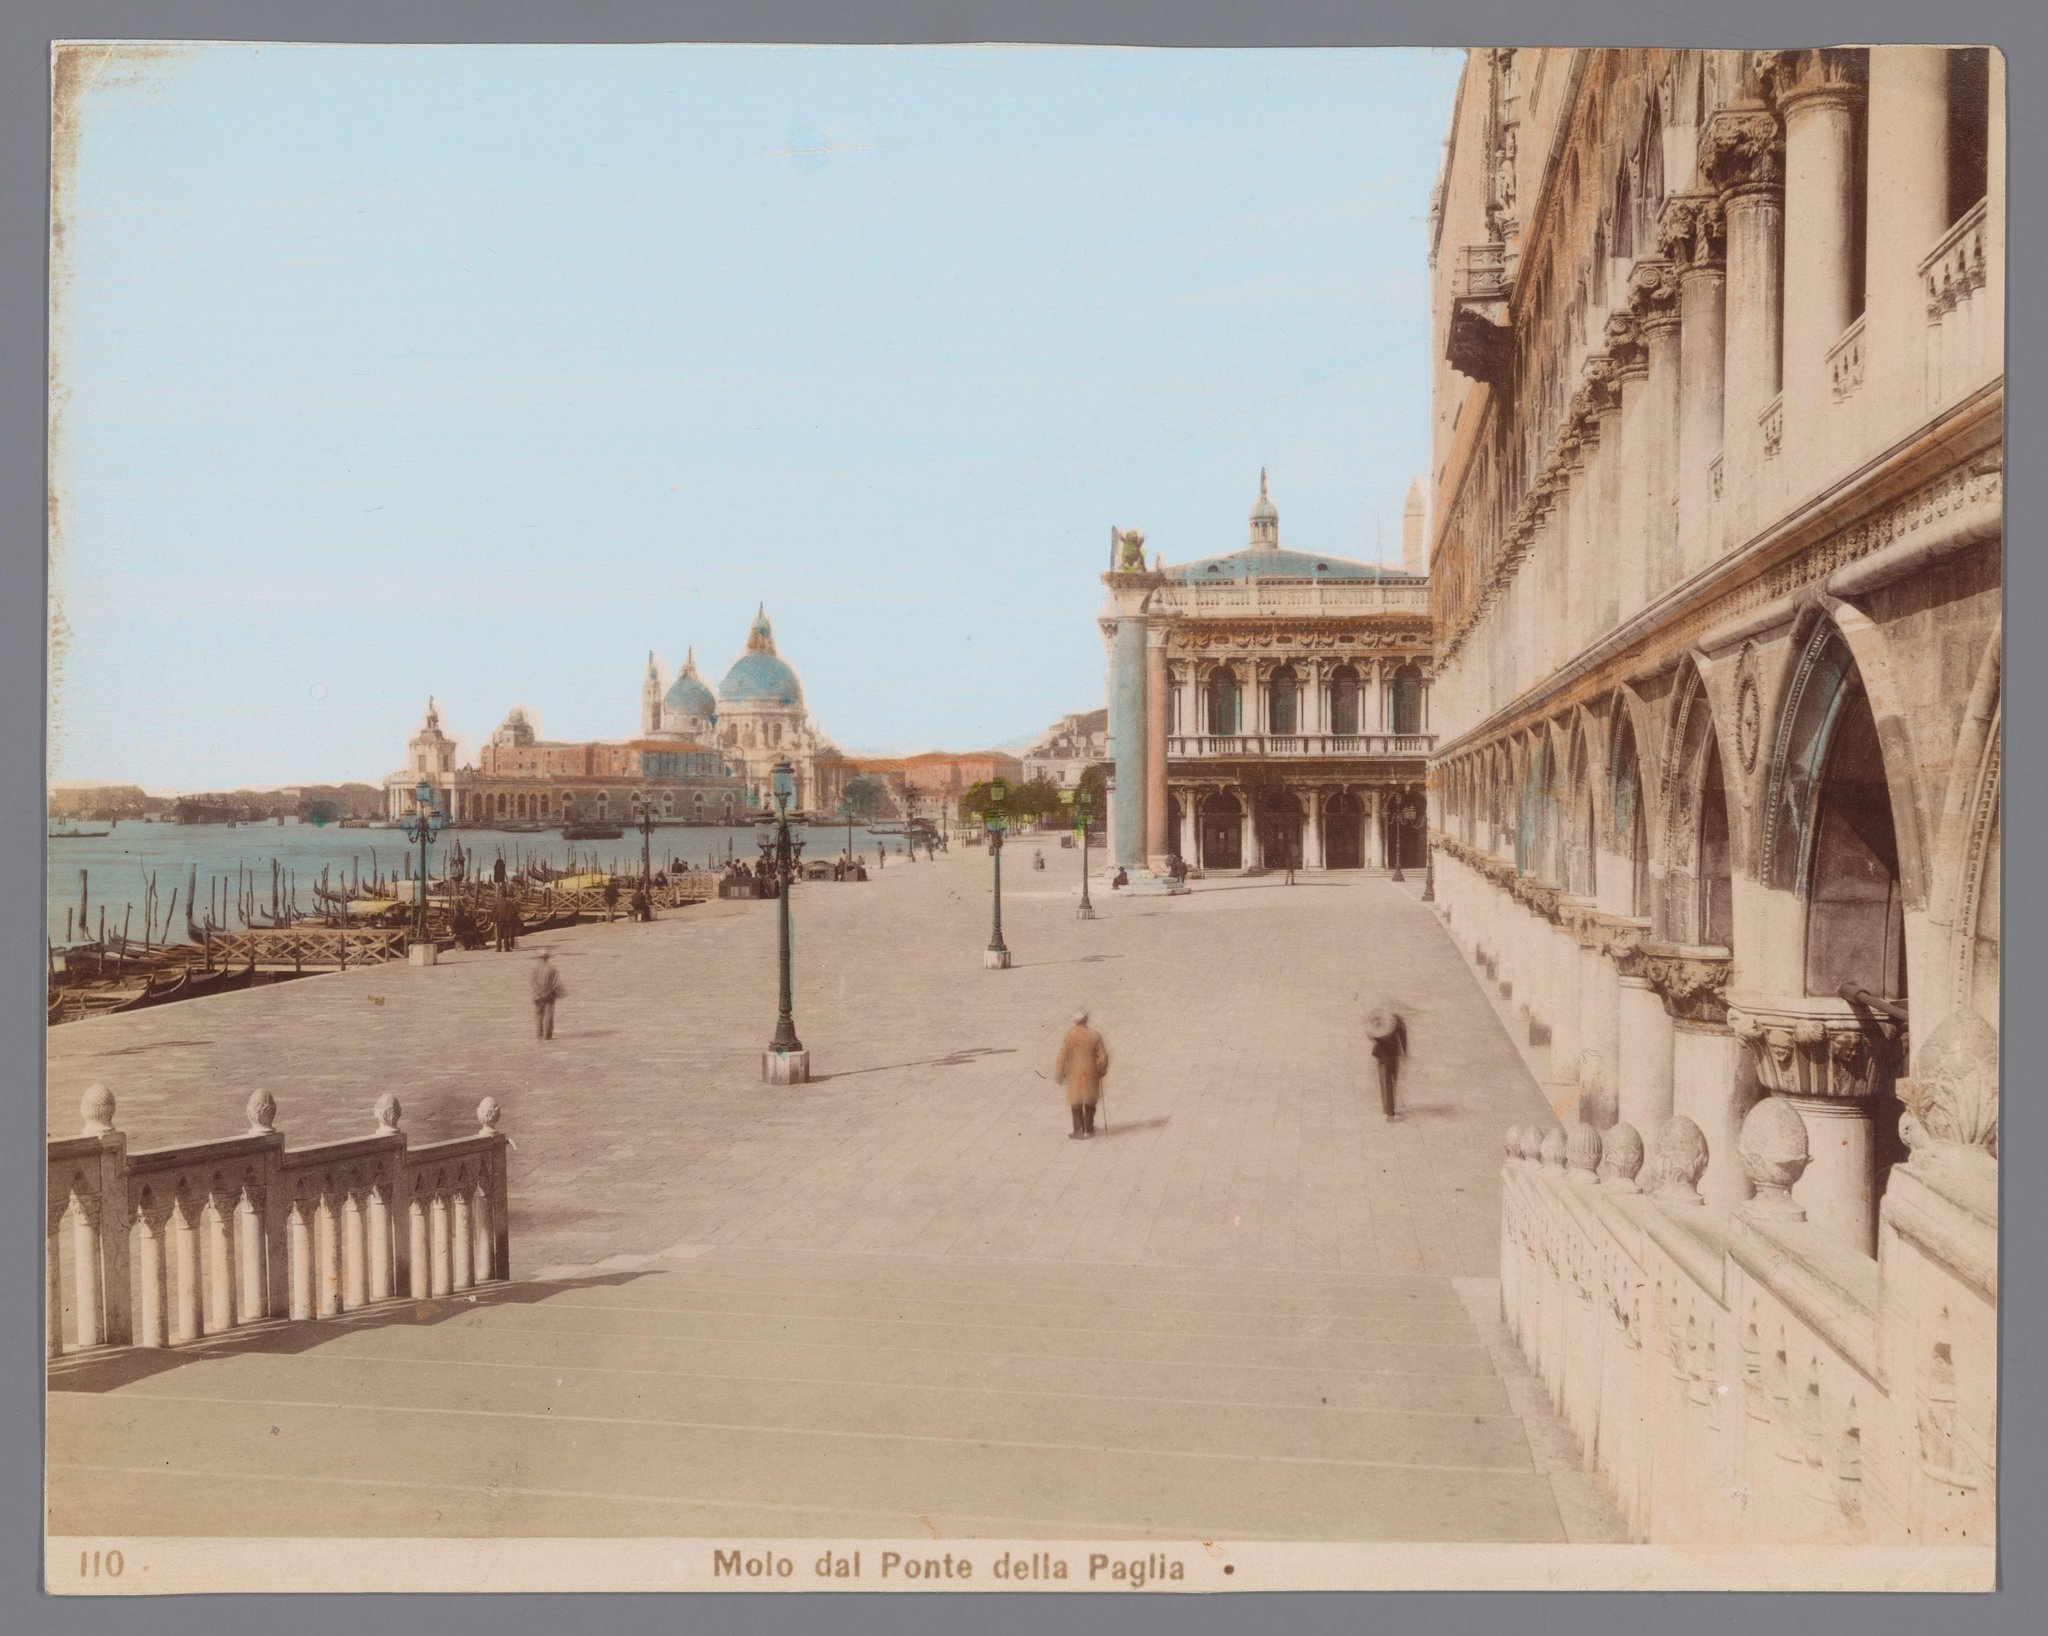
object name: photograph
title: Kade bij de Ponte della Paglia te Venetië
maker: Anonymous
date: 1851-1900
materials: paper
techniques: albumen print, hand coloring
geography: venice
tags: church (exterior), quay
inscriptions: number: ‘110.’